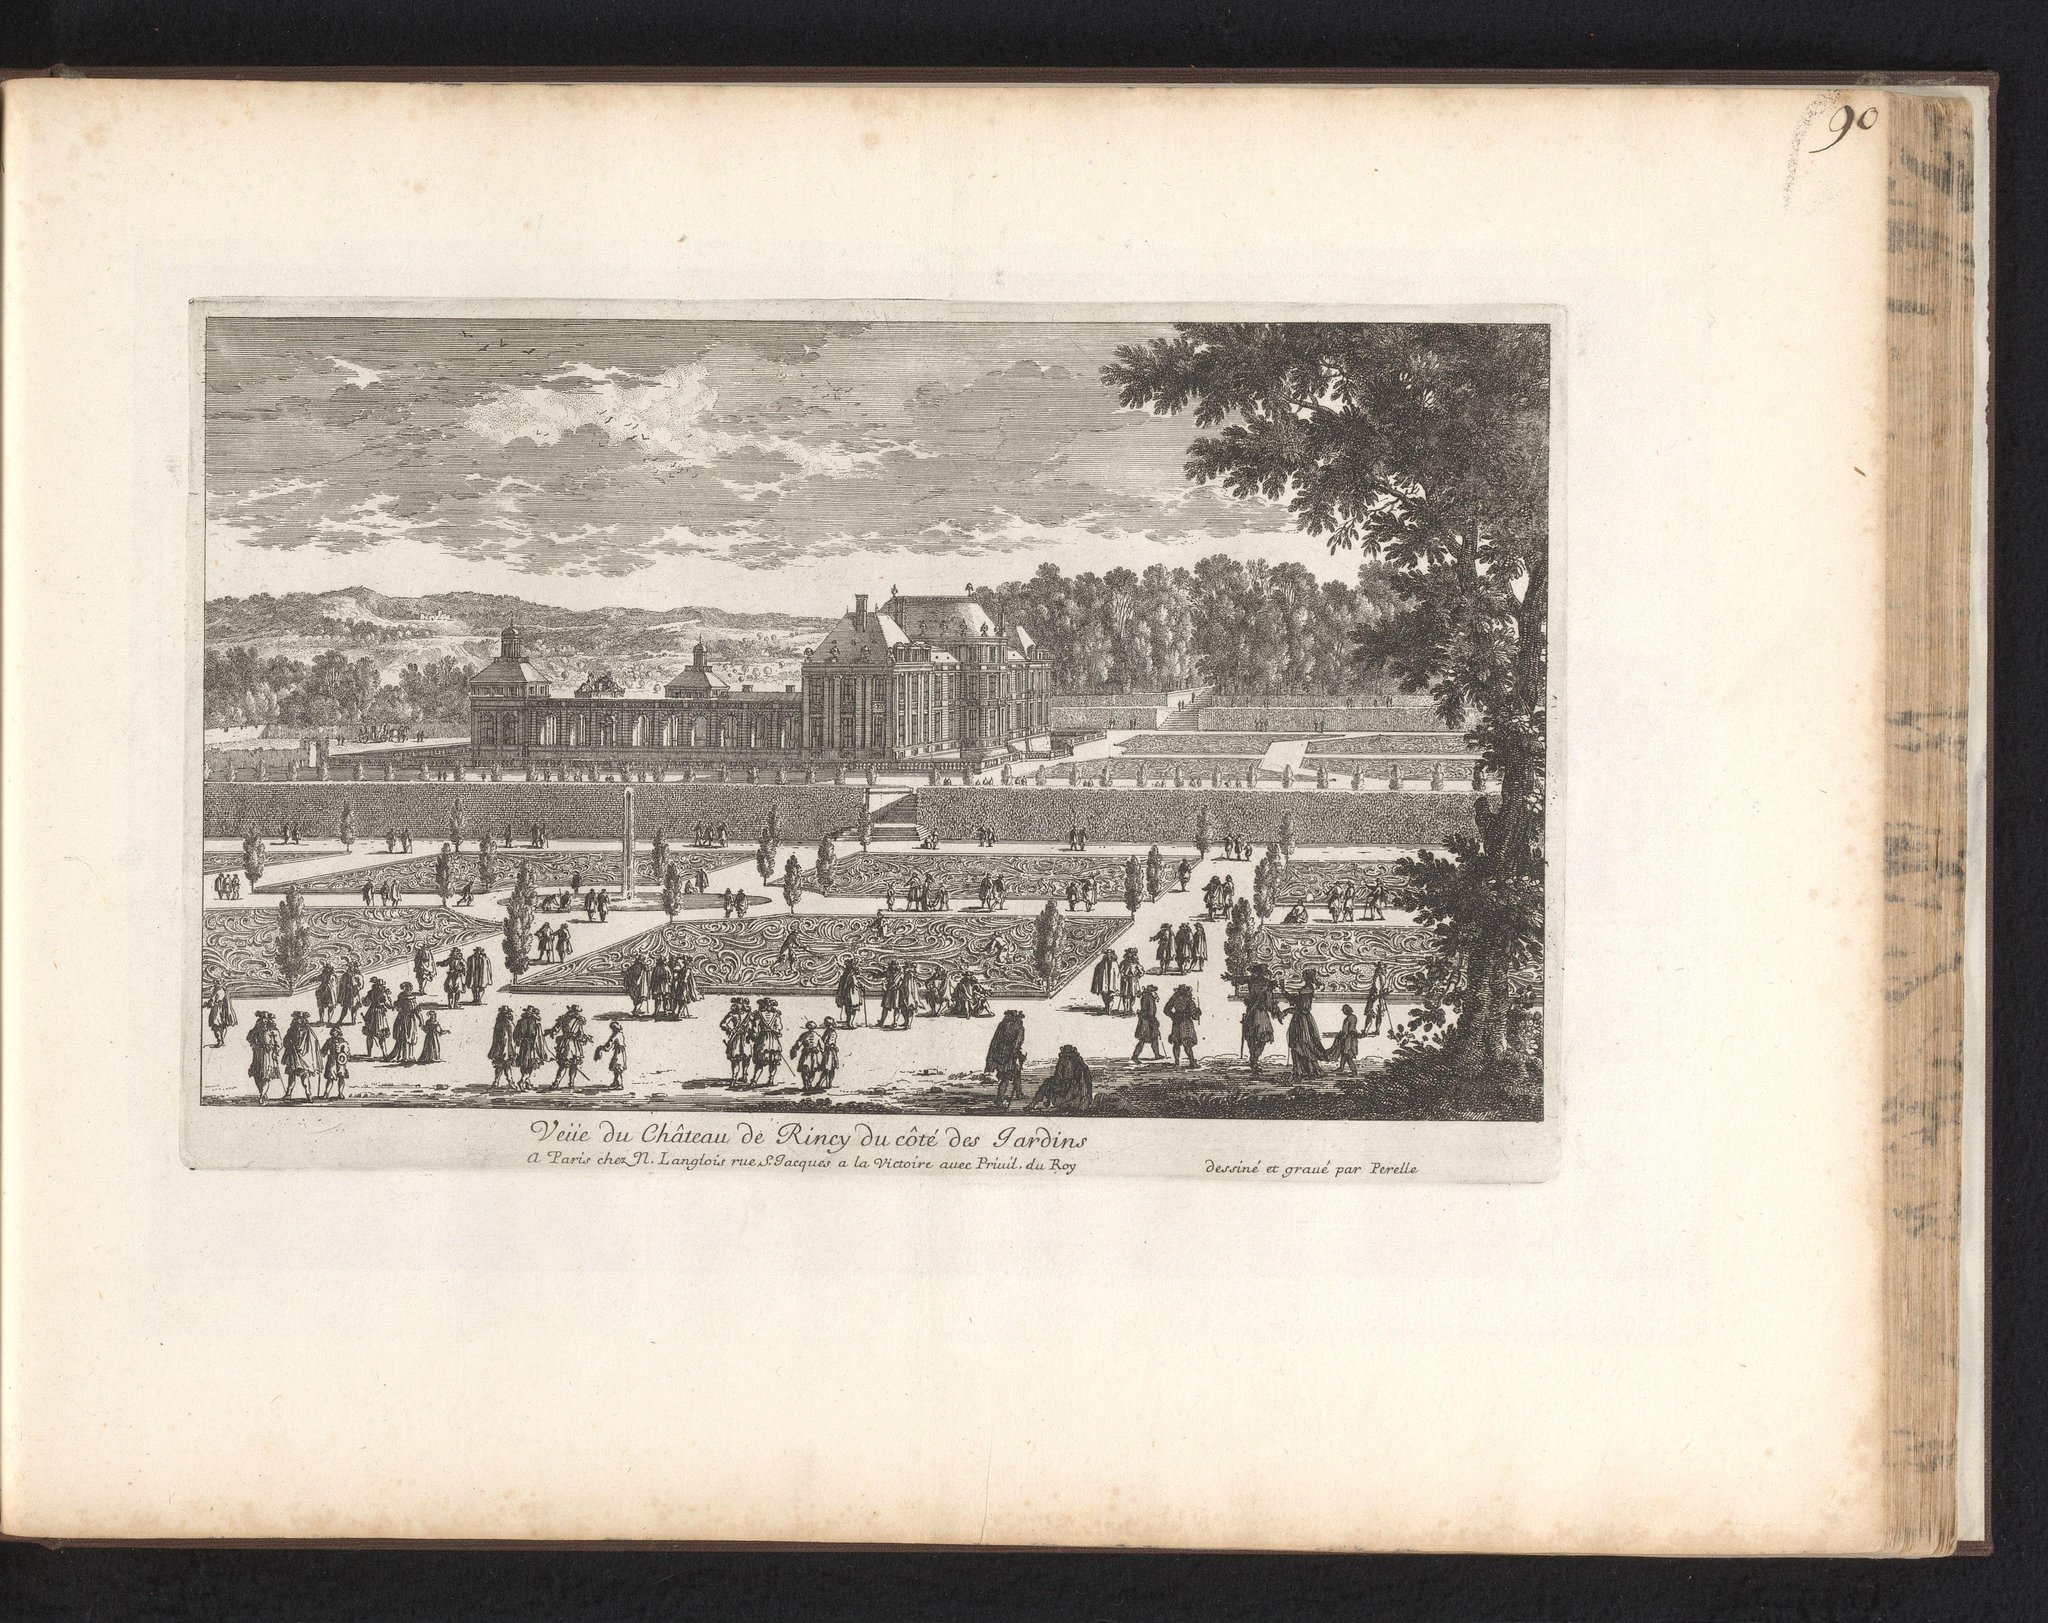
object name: album leaf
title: Recueil de vues de monuments de Paris, des principales résidences royales et des principaux châteaux de France et de Rome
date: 1650-1695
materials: paper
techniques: etching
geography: paris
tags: french or architectonic garden; formal garden, landscape with tower or castle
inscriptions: collector's mark: Lugt 2228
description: Prenten met het signatuur 'Perelle' kunnen zowel door vader Gabriel als door zonen Nicolas en Adam gemaakt zijn. De uitgevers vader en zoon Nicolas Langlois worden allebei vermeld als N. Langlois op hetzelfde adres.